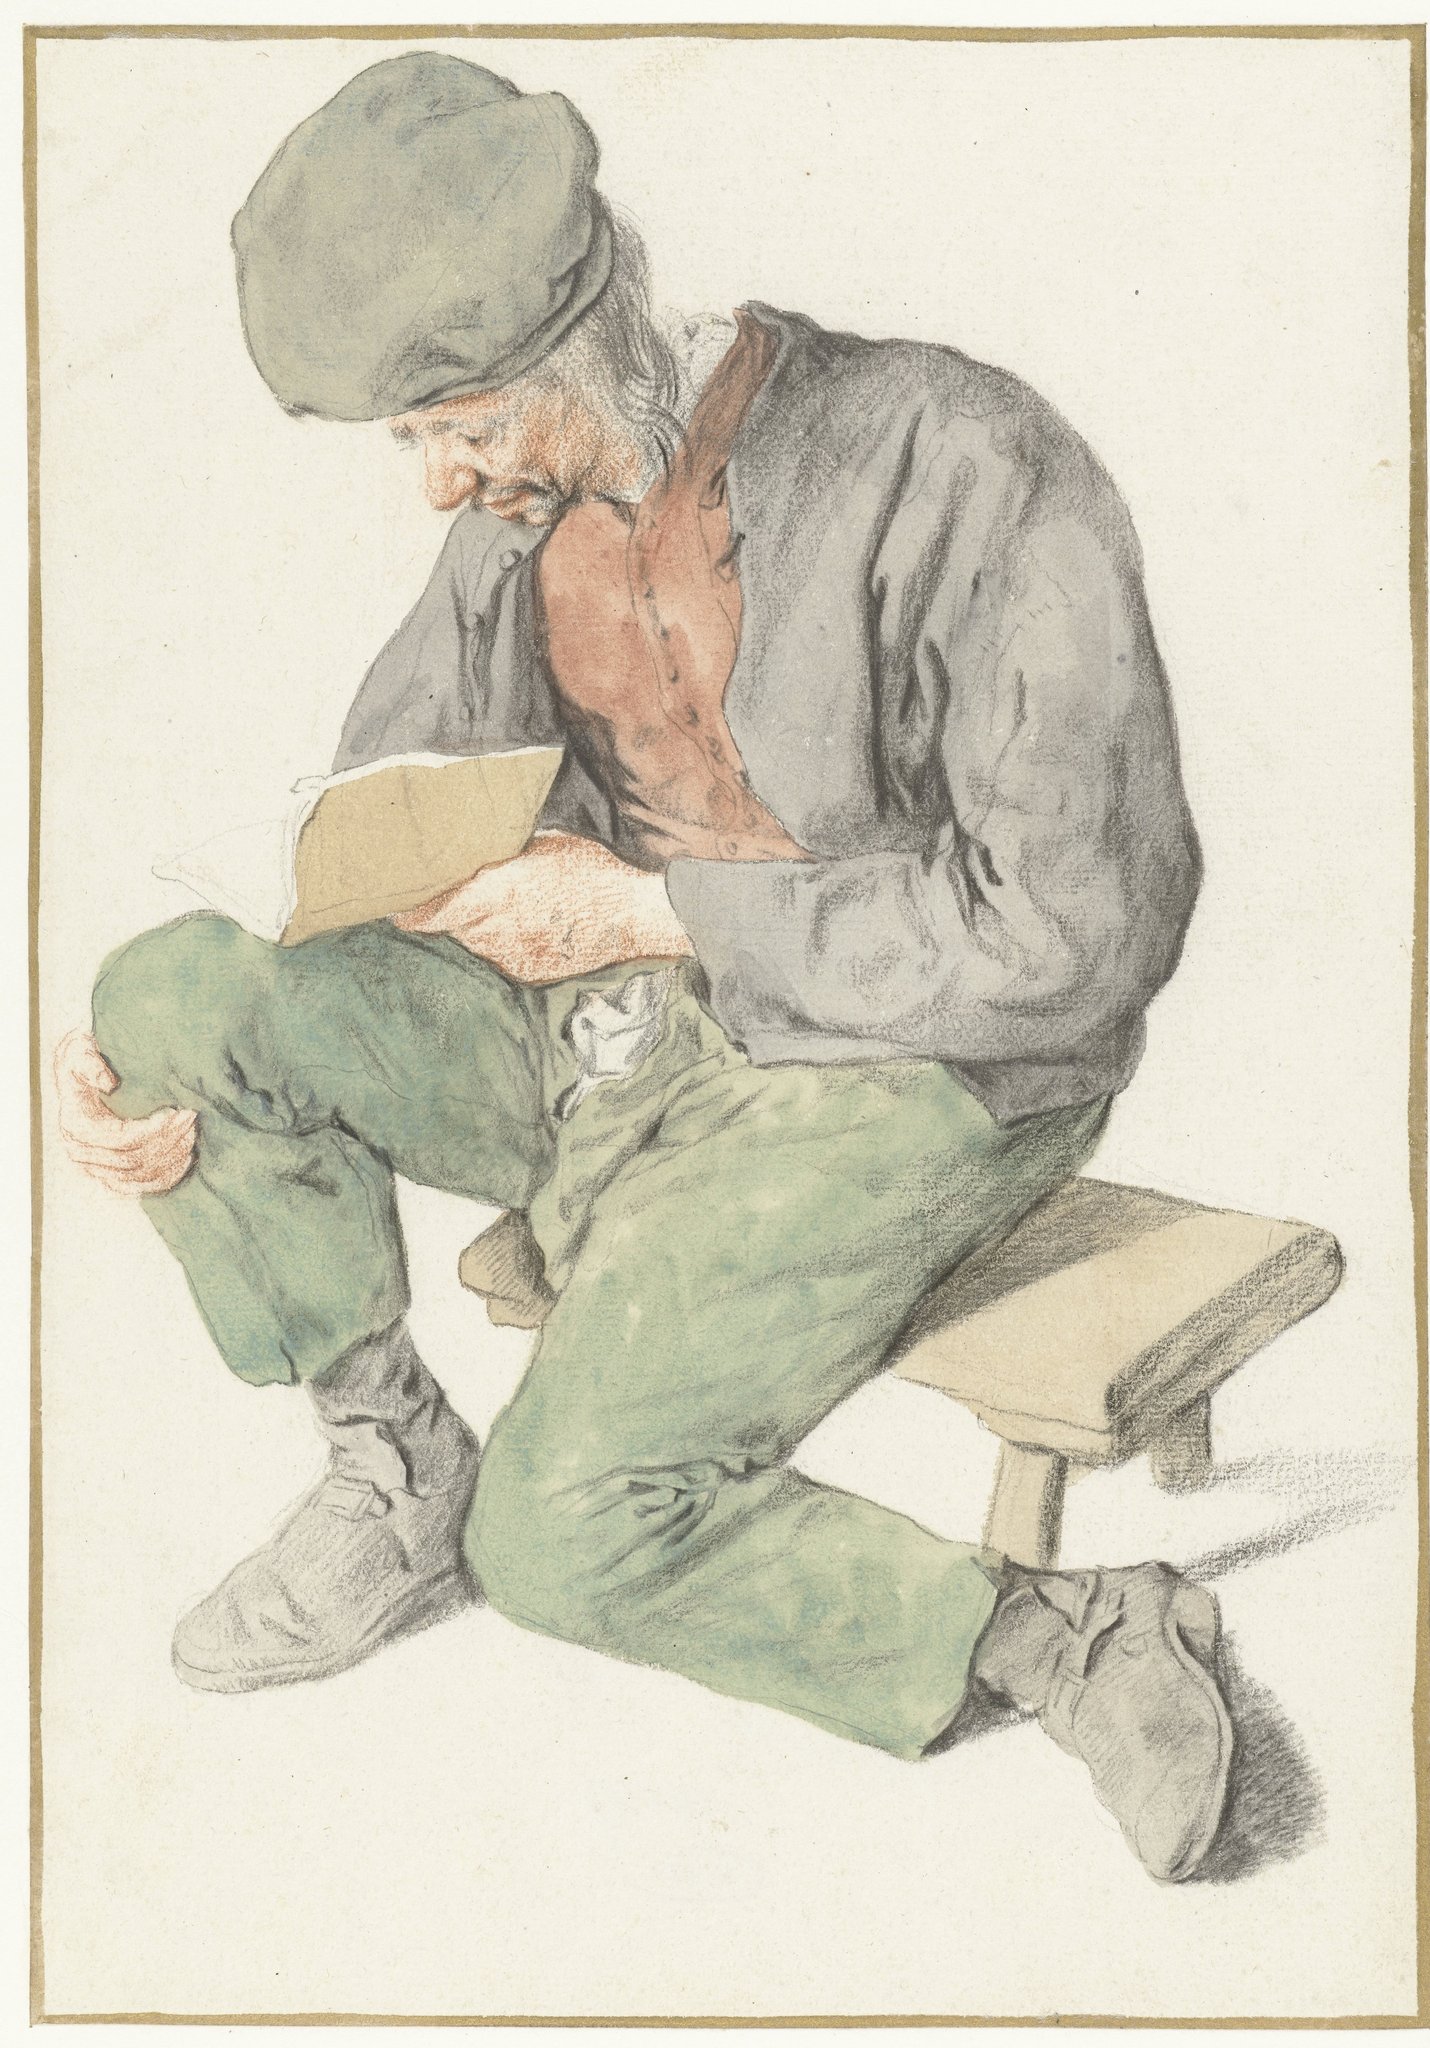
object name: drawing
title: Seated Man Reading, Facing Left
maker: cornelis dusart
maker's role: draughtsman, painter, print maker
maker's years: 1660-1704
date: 1690-1700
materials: chalk, paper, watercolor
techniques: brush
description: This man, engrossed in his book, is almost a mirror image of the lad in yellow trousers. The style of drawing and the materials are strikingly similar, and the sheets are almost the same size. It is quite possible that the two drawings once formed a set. The – originally identical – gold framing lines around the drawings show that the works once belonged to the same collection.